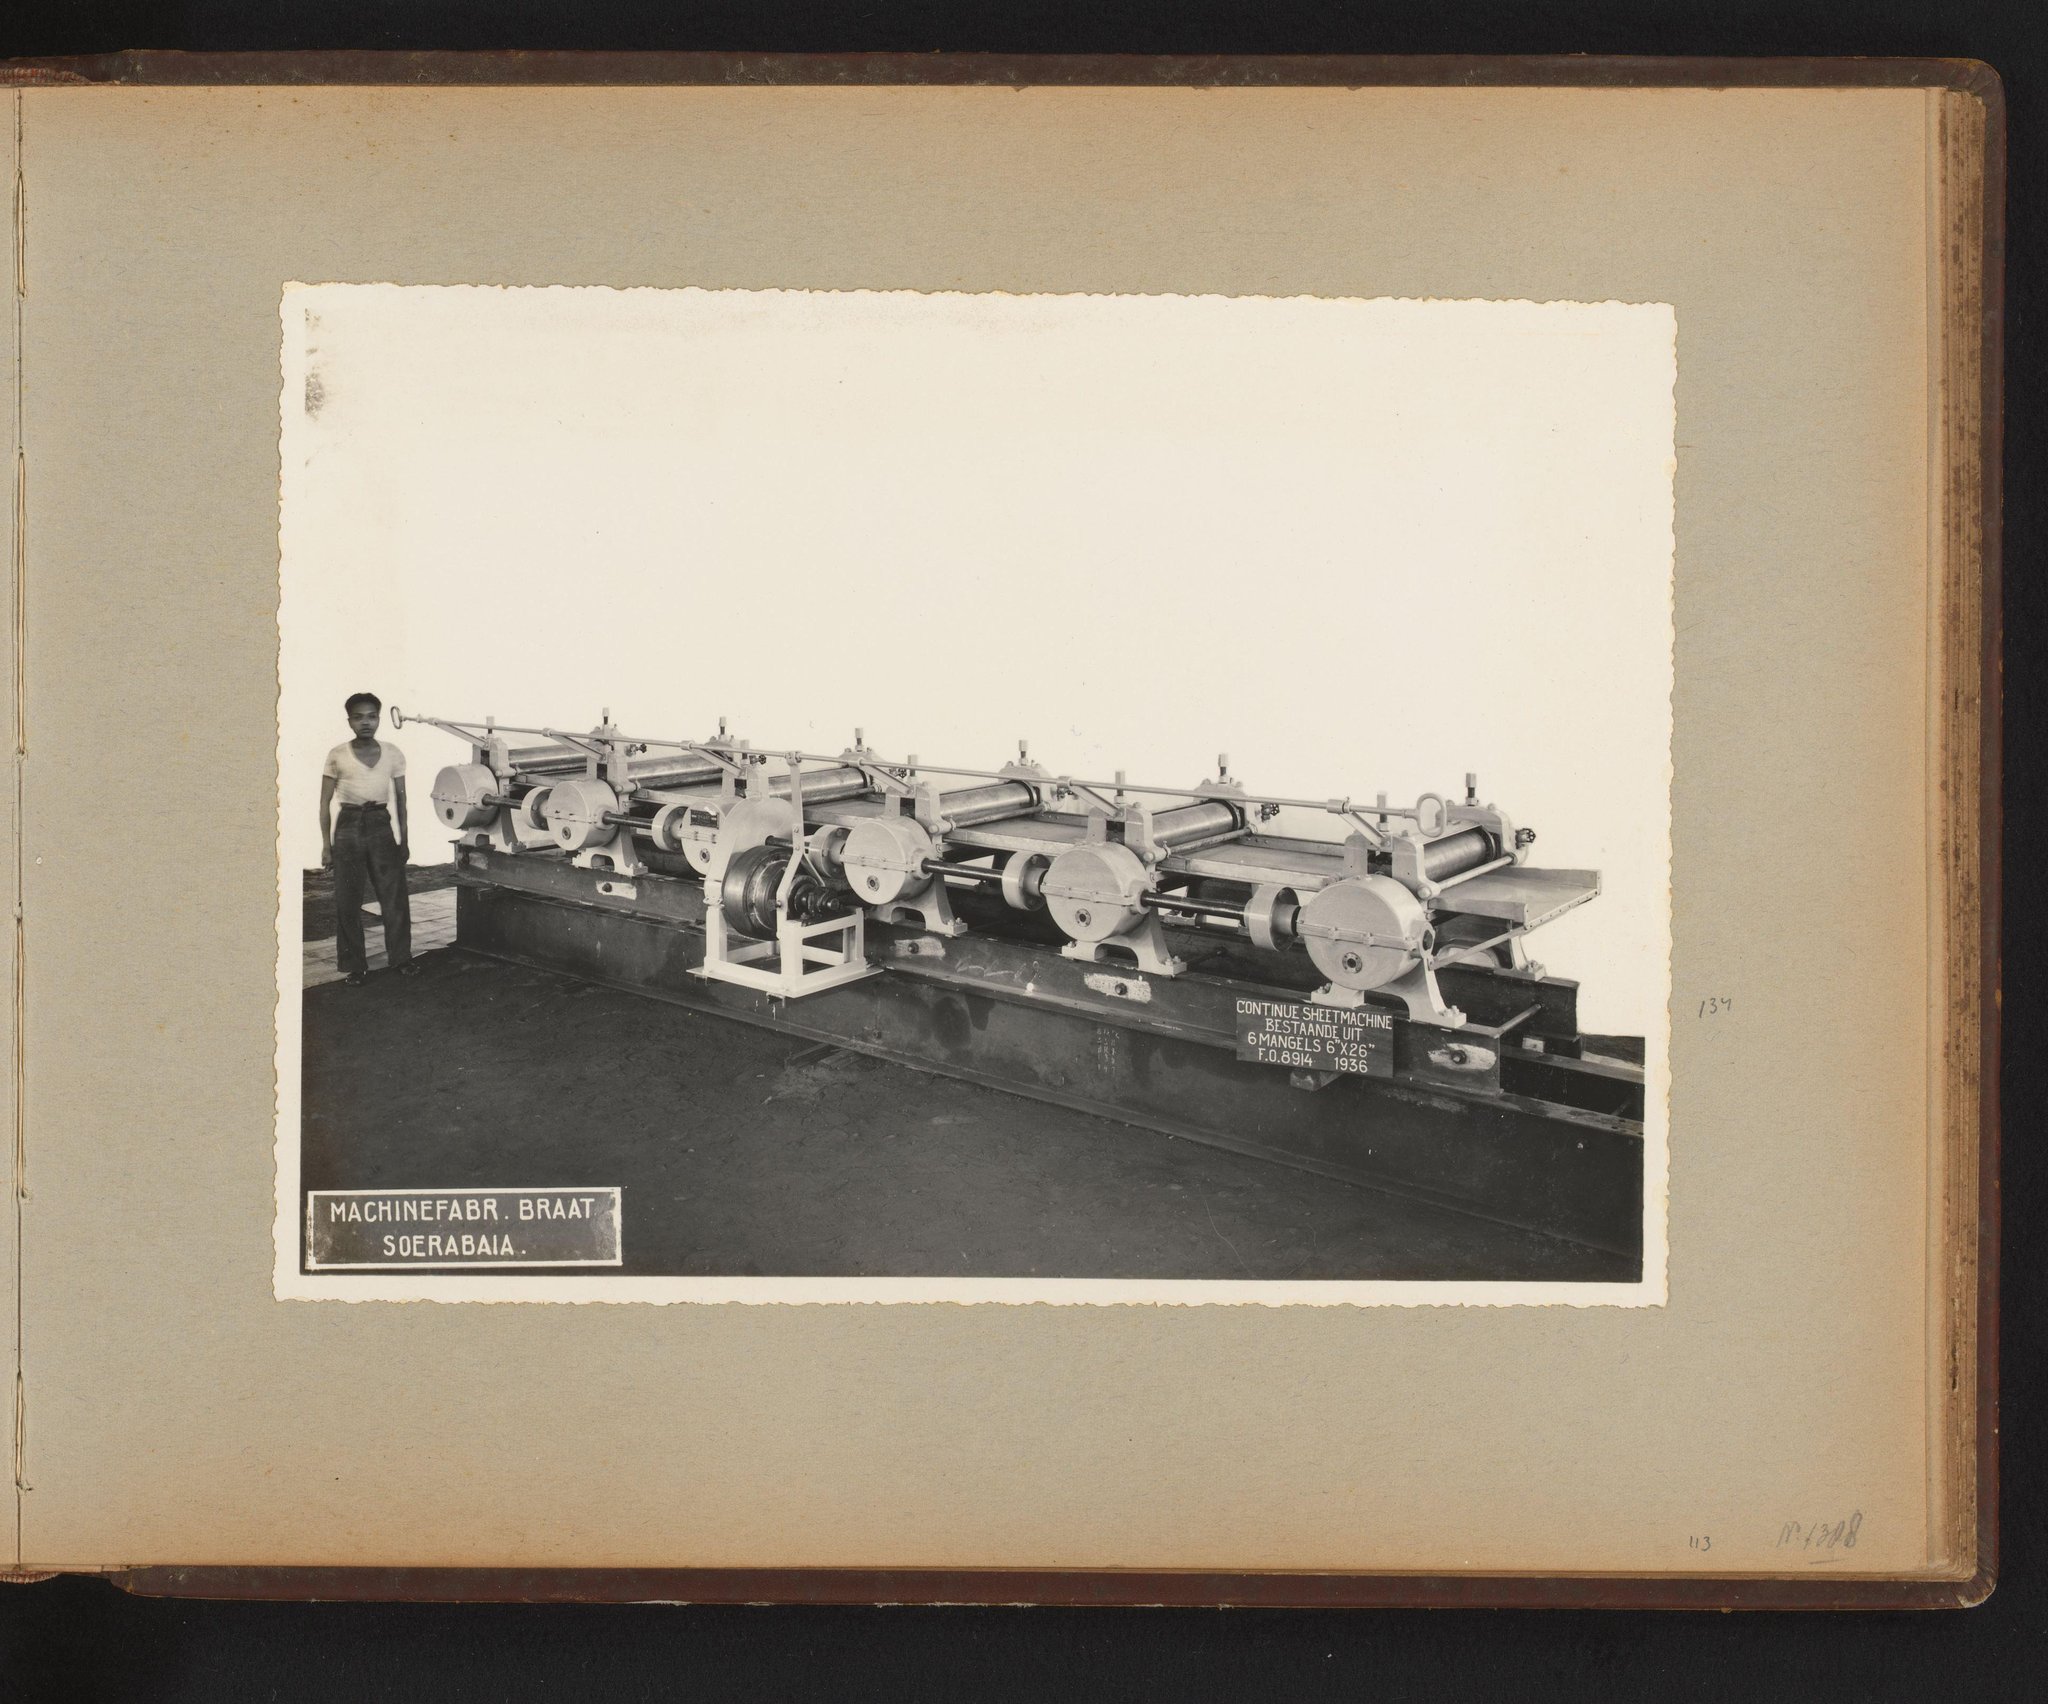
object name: album leaf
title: Continue sheetmachine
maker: Anonymous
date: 1936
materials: cardboard, photographic support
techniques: gelatin silver print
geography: surabaya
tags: machines; parts of machines; tools and appliances, java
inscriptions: date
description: Albumblad met een foto van een sheetmachine (waarschijnlijk bestemd voor een rubberfabriek), 1636. Onderdeel van een fotoalbum met foto's van machines en constructies van de N.V. Machinefabriek Braat te Soerabaja, Soekaboemi en Tegal uit de periode 1931-1937.